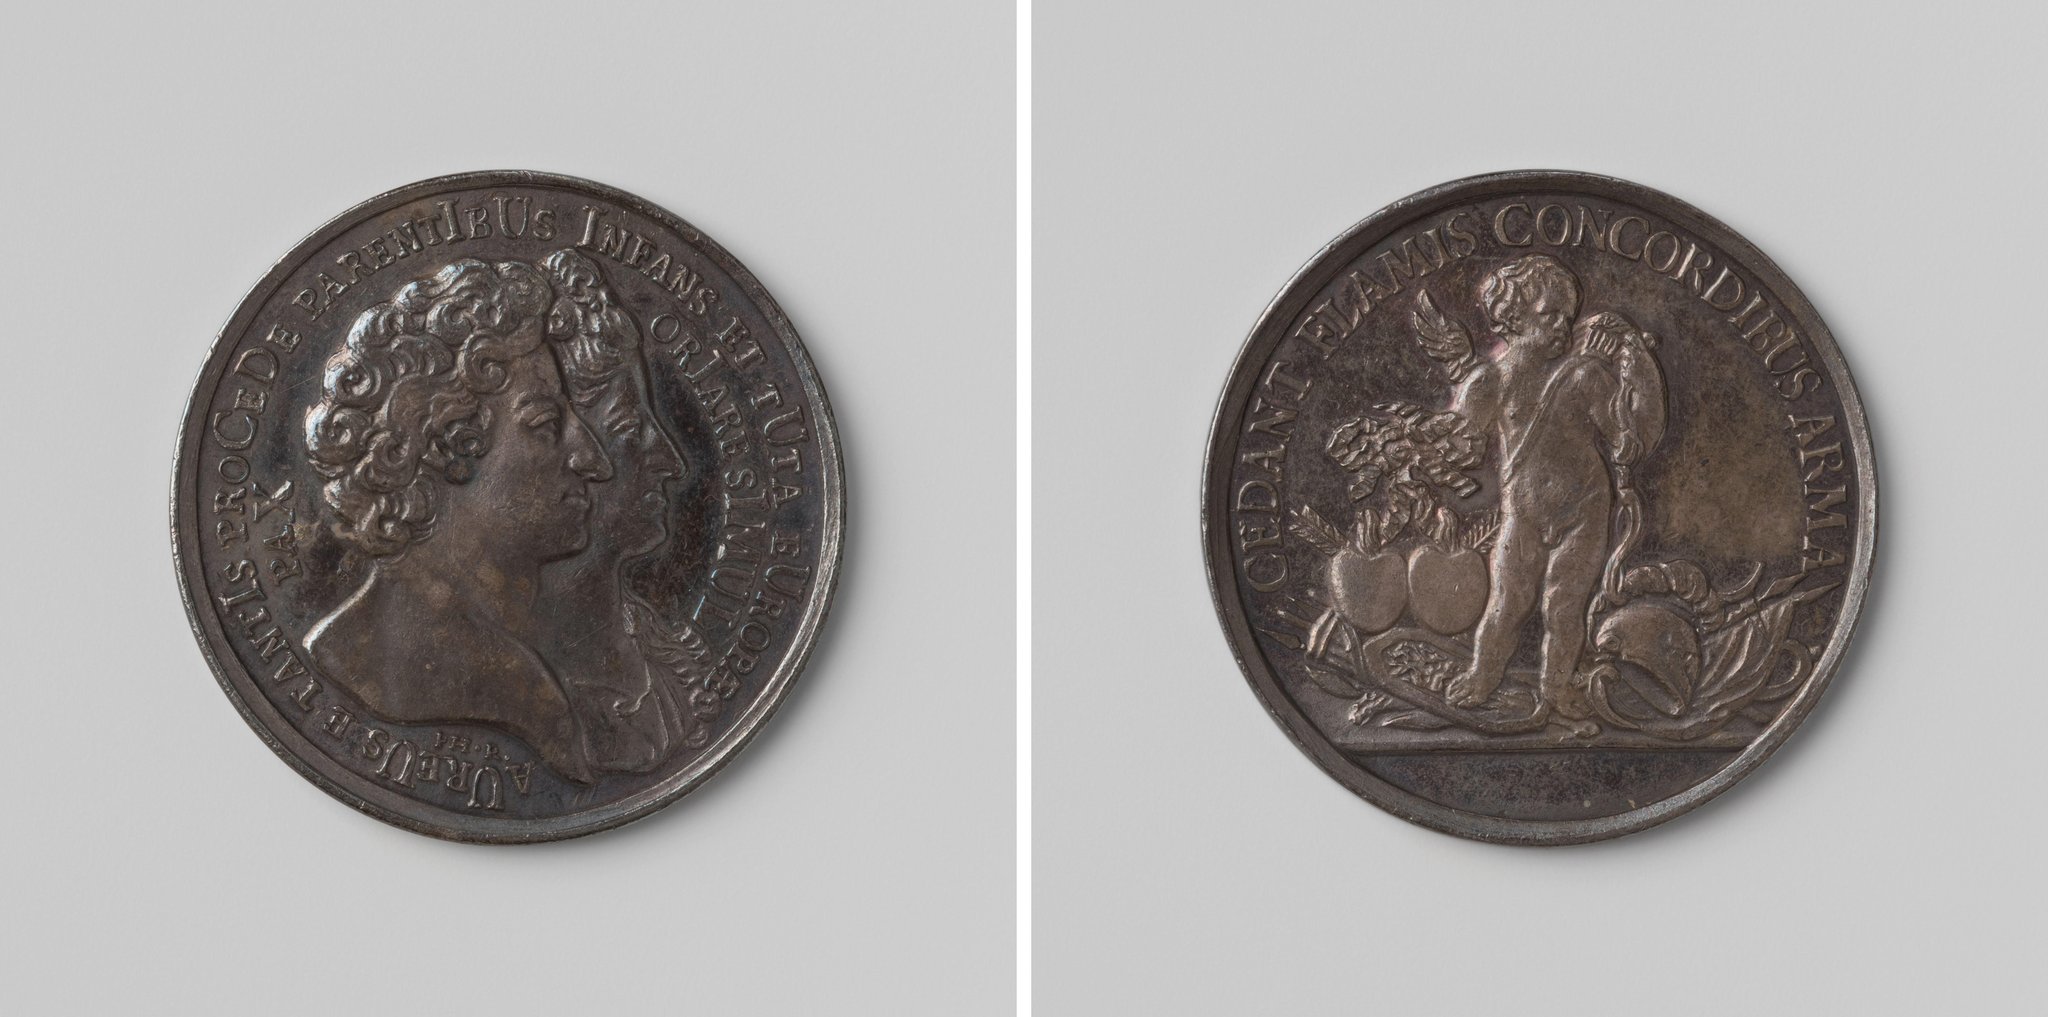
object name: jeton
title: Huwelijk van Maximiliaan II Emanuel, keurvorst van Beieren met Theresa Kunigonde Sobieski, prinses van Polen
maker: Anonymous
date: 1695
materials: copper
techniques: striking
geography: antwerp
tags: venice, maximiliaan ii emanuel (keurvorst van beieren)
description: Koperen penning. Voorzijde: borststuk man en vrouw binnen tweeregelig omschrift. Keerzijde: staande temidden van wapentuig houdt Amor twee met lint samengebonden, vlammende harten vast binnen omschrift